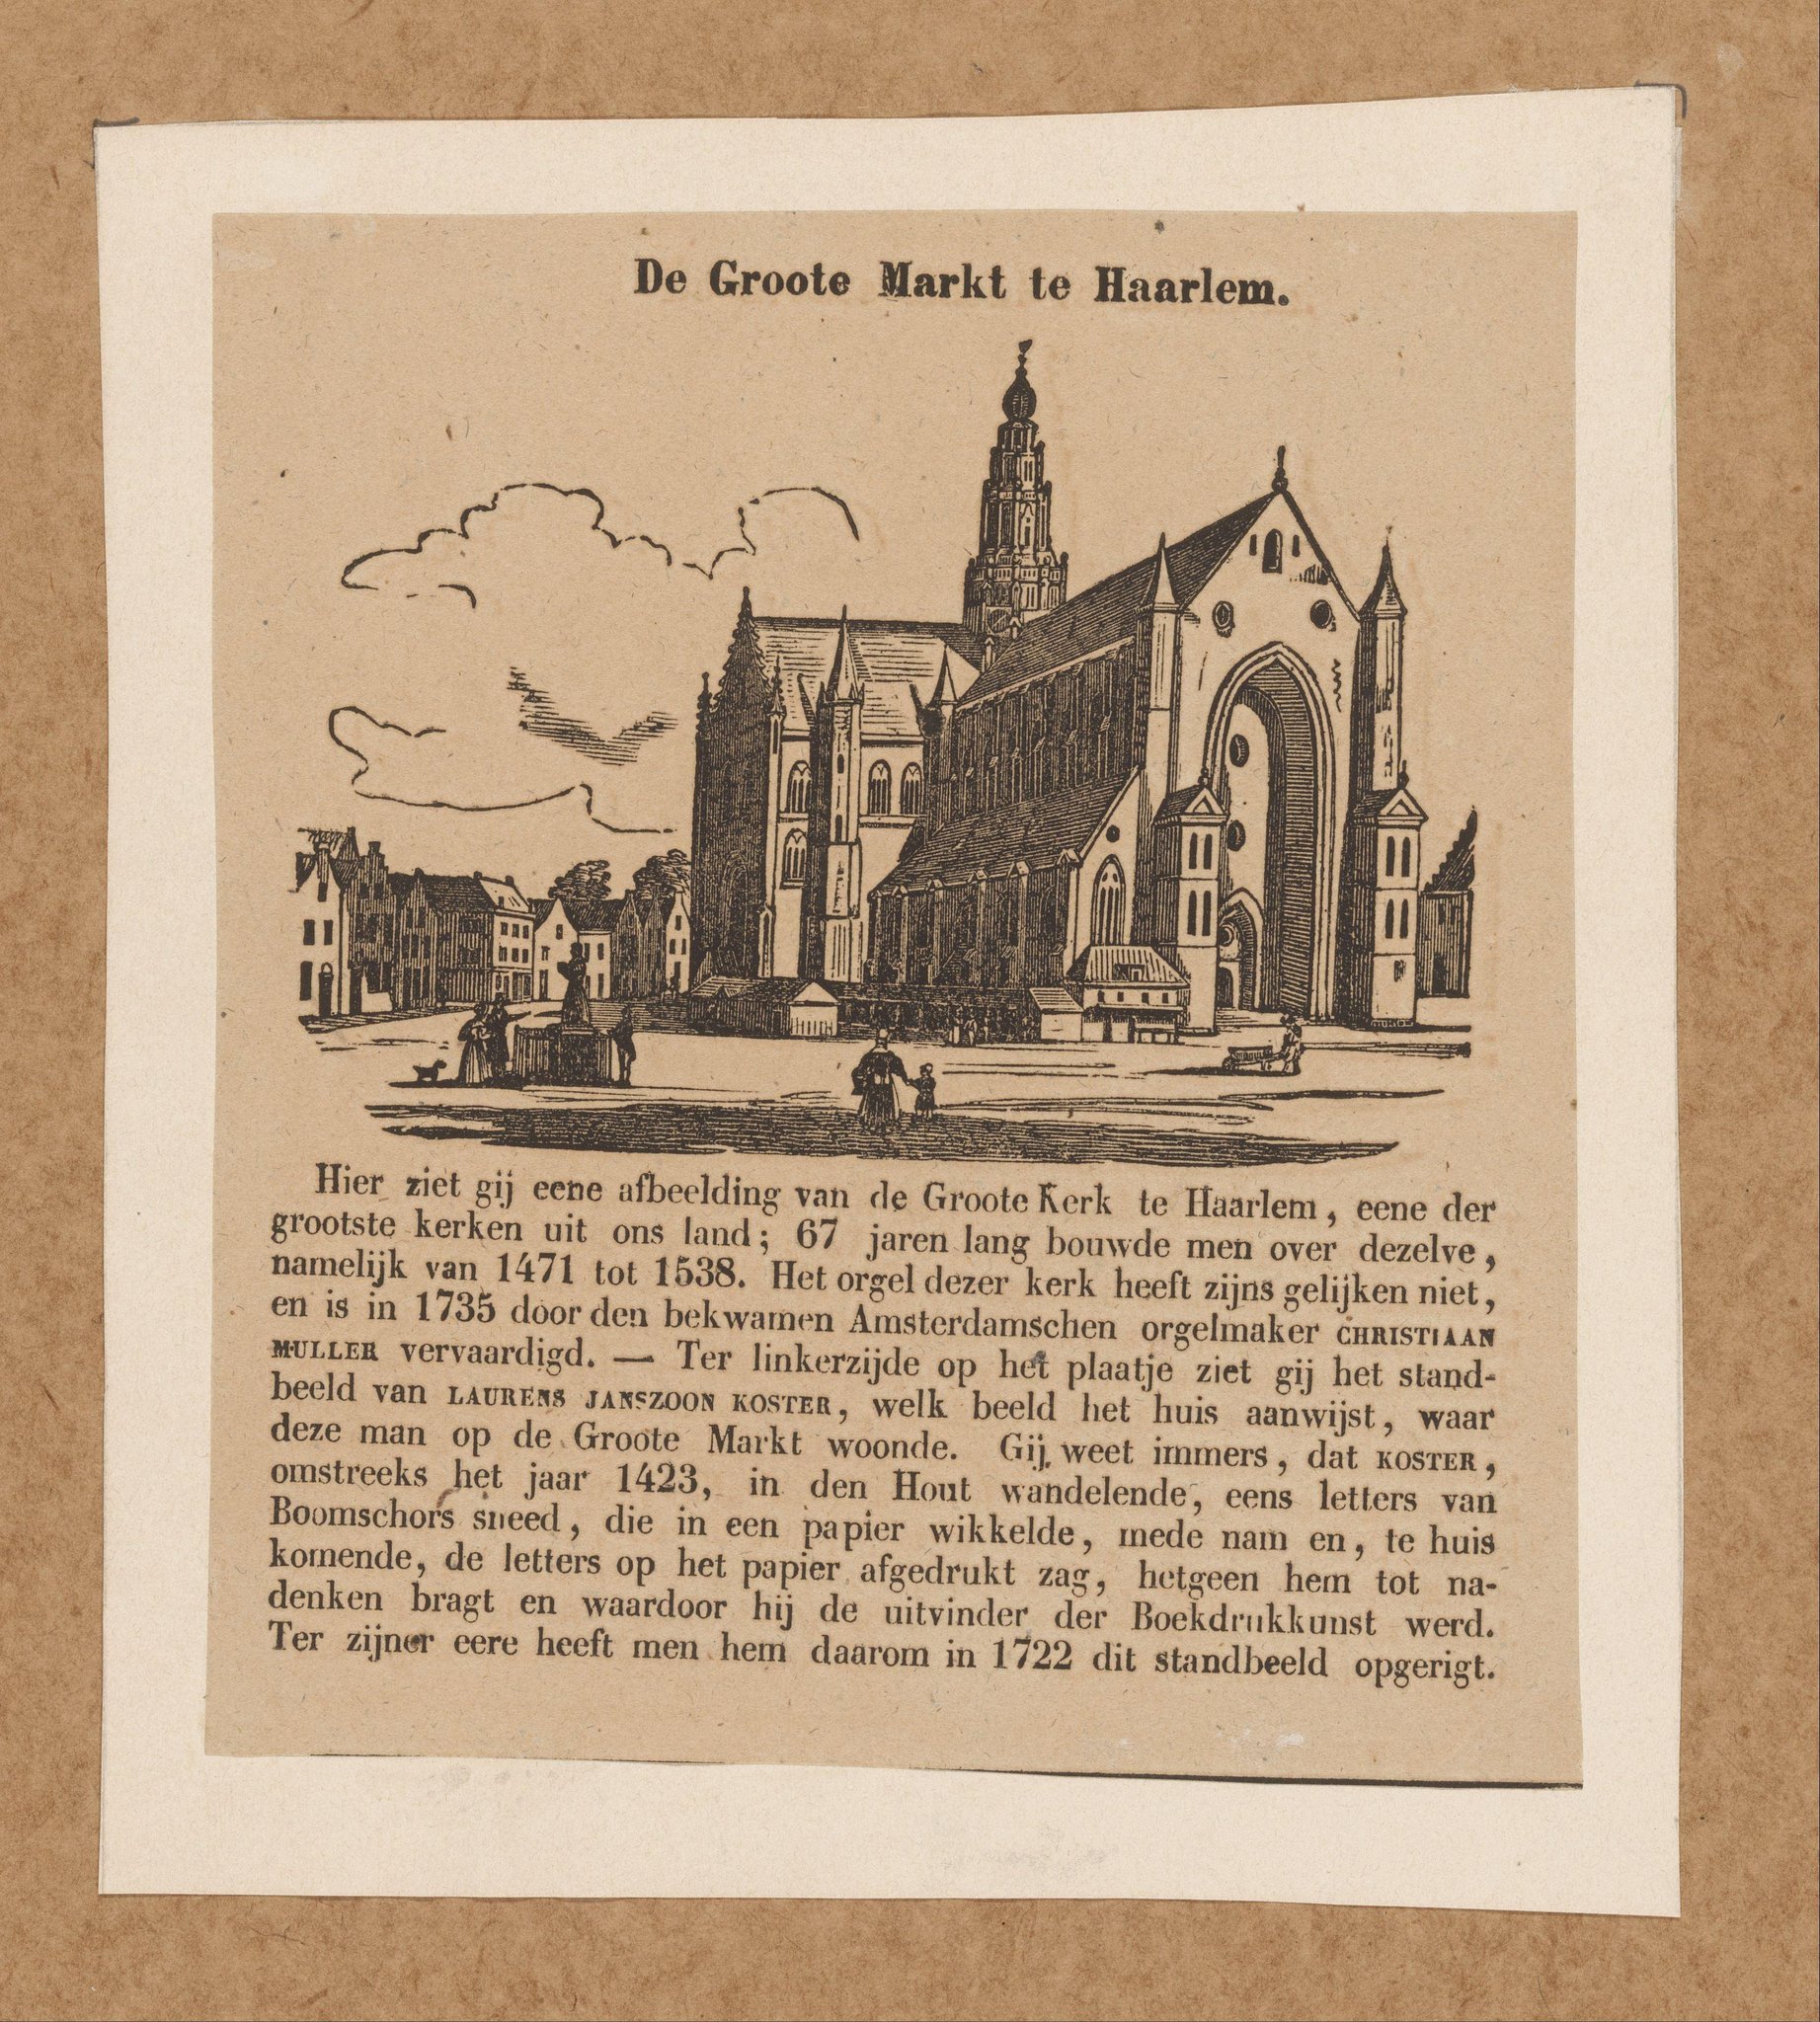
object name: print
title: De Groote Markt te Haarlem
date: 1839-1841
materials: paper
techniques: woodcut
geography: purmerend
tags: interior of church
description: Versneden blad waarop vier soortgelijke houtsneden voorkomen. Het blad is getiteld "Prenten-Magazijn voor de Jeugd, no. 2".